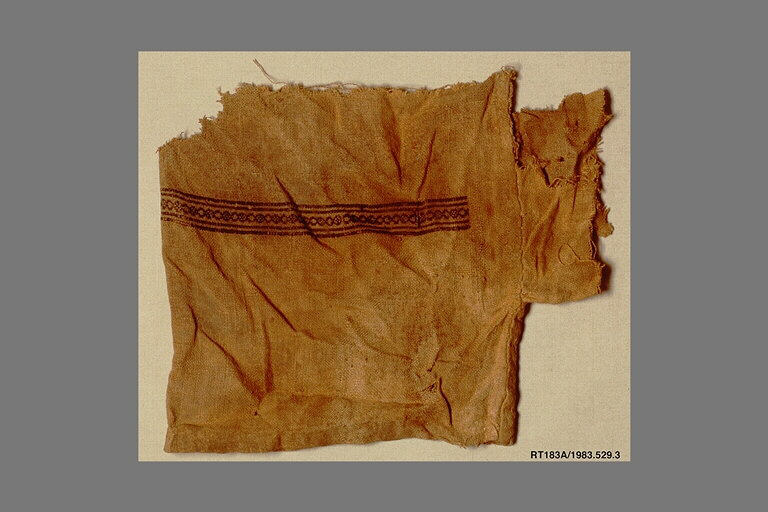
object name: textile fragment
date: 1301-1500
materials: linen, silk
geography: egypt